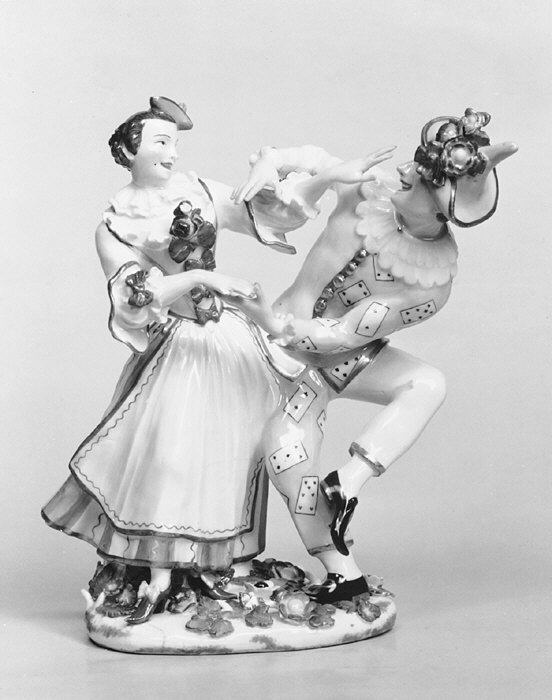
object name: group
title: Harlequin and Columbine dancing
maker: meissen manufactory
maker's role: manufactory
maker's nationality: german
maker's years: 1710-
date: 1744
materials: hard paste porcelain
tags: men,women,dancing